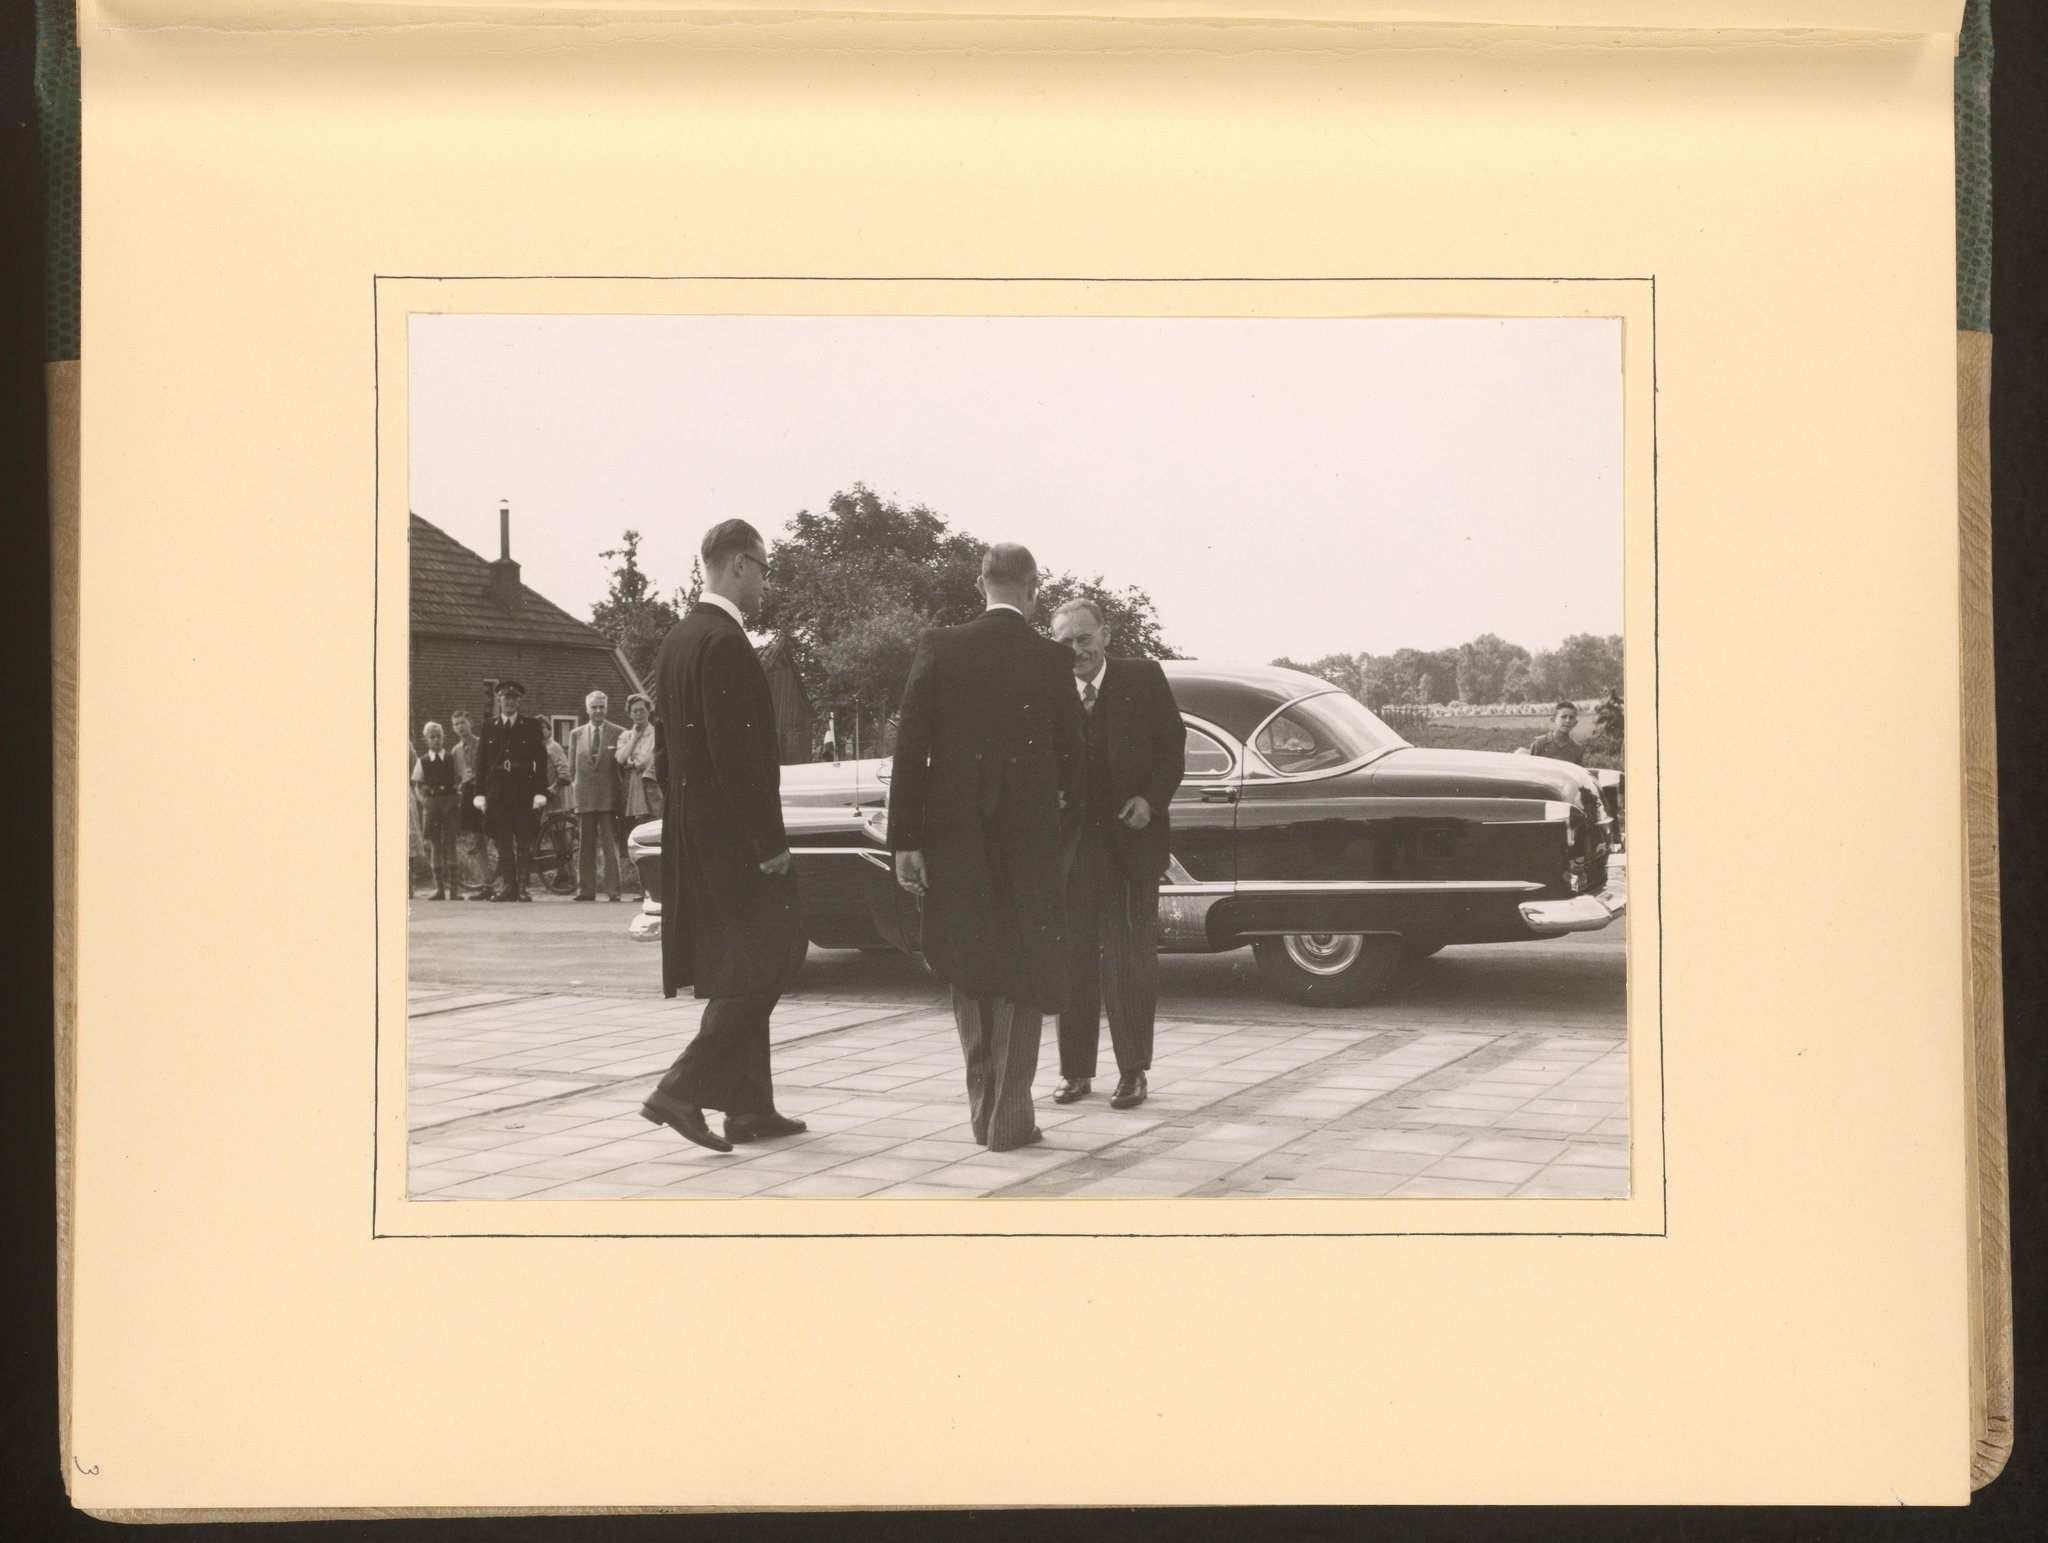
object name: photograph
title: Aankomst van Drees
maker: Anonymous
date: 1953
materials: paper, photographic support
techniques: gelatin silver print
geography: lochem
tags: amsterdam, the hague, willem drees, prime minister, being welcomed ~ travelling, automobile, old-people's home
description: Aankomst van Drees, voor de auto wordt hij verwelkomd door twee heren. Onderdeel van het fotoalbum over de opening van het bejaardenhuis De Berkelhof in Lochem door premier Willem Drees op 8 augustus 1953.